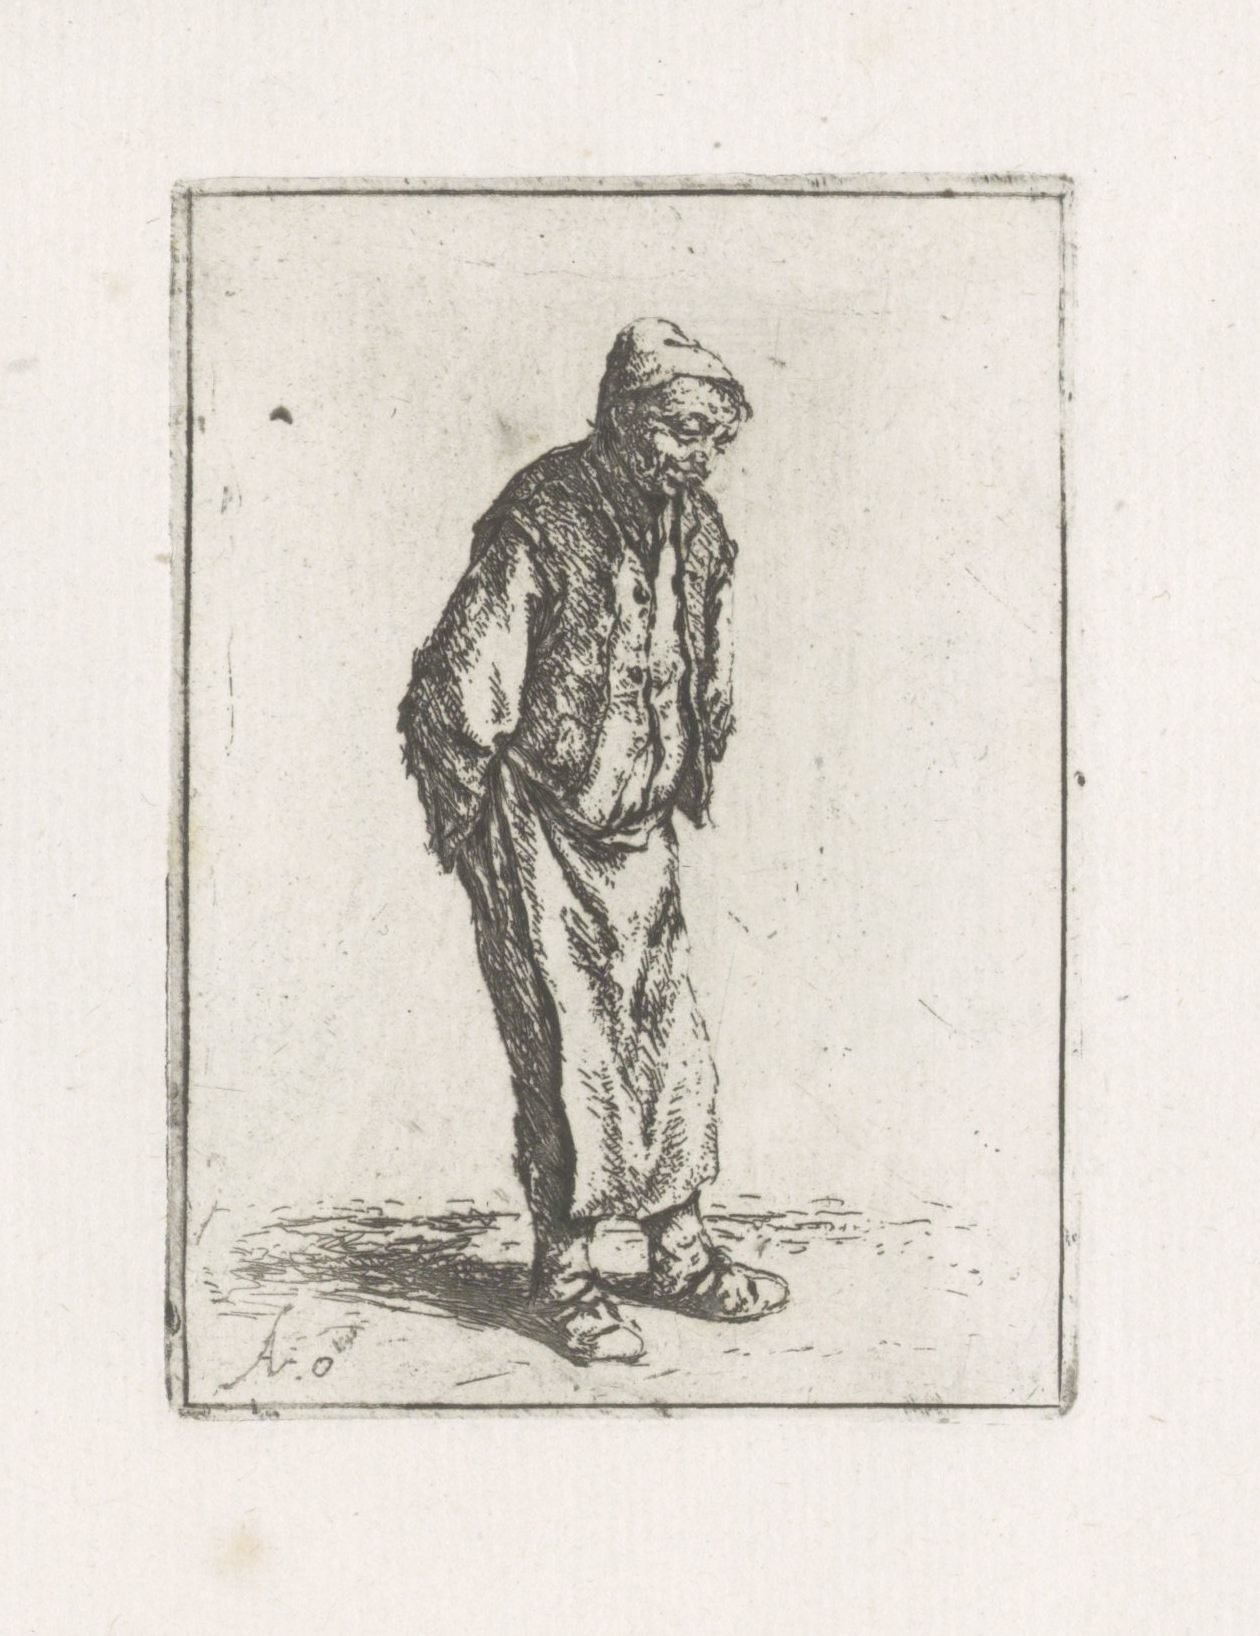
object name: album leaf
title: Staande man met de handen op de rug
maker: adriaen van ostade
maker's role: draughtsman, painter, print maker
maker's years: 1610-1685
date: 1646-1649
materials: paper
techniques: etching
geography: haarlem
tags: arm bent behind the back - aa - both arms or hands (+ standing), apron, adult man (+ standing)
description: Deze prent maakt deel uit van een album.